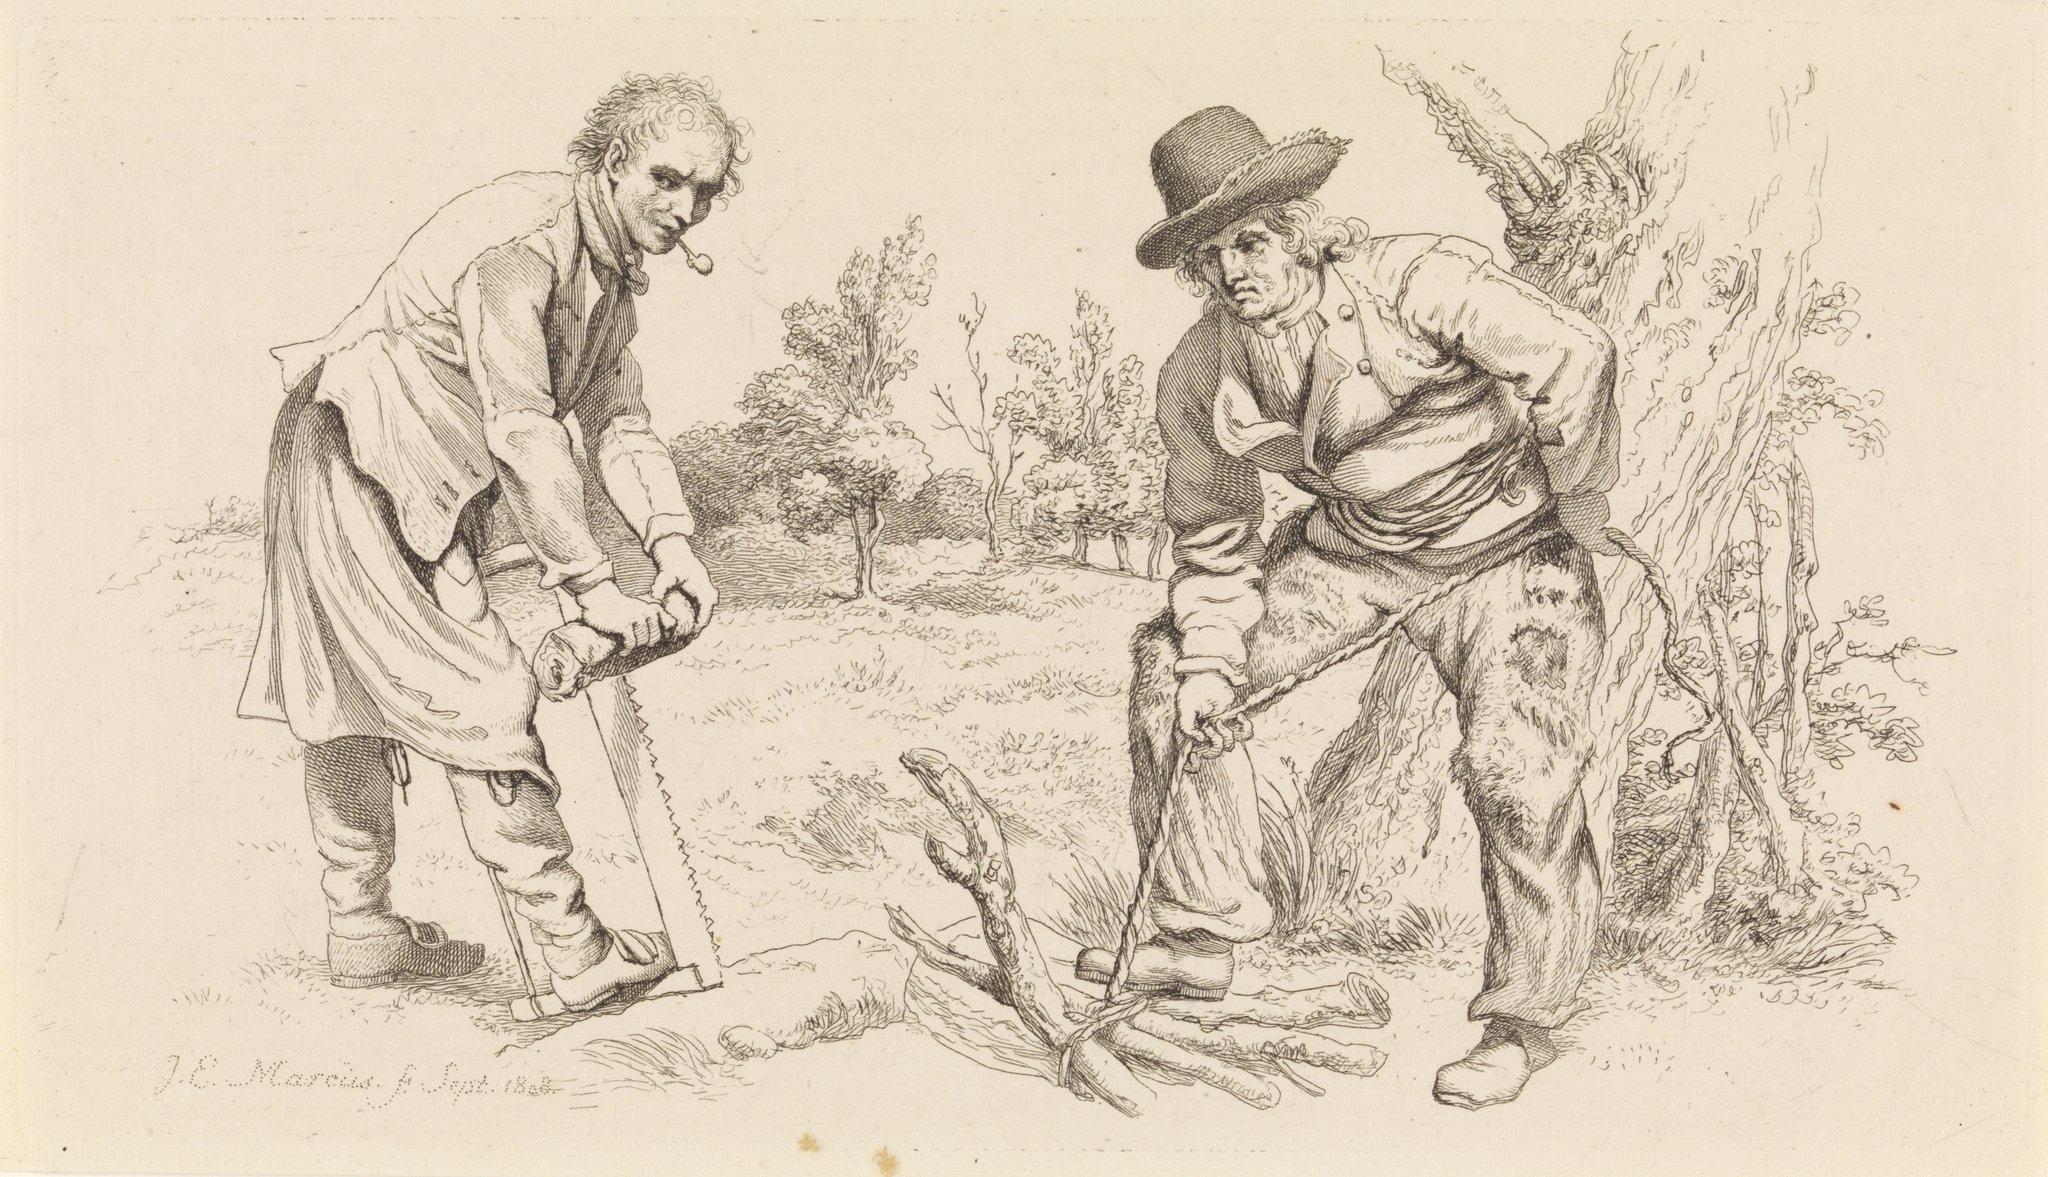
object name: print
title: Studieblad met een houtsprokkelaar en een man met zaag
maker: jacob ernst marcus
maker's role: draughtsman, print maker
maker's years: 1774-1826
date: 1808-1809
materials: paper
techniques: etching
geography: amsterdam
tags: industries ~ wood, tools, aids, implements ~ crafts and industries: saw, tools, aids, implements ~ crafts and industries: rope, sawing (industrial process)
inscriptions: collector's mark: Lugt 2228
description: Serie voor het eerst uitgegeven door Jacob Ernst Marcus onder de titel Studiebeelden en Fragmenten. Amsterdam: ca.1816. Later heruitgegeven als: Studie-prentwerk/ Etudes gravées.